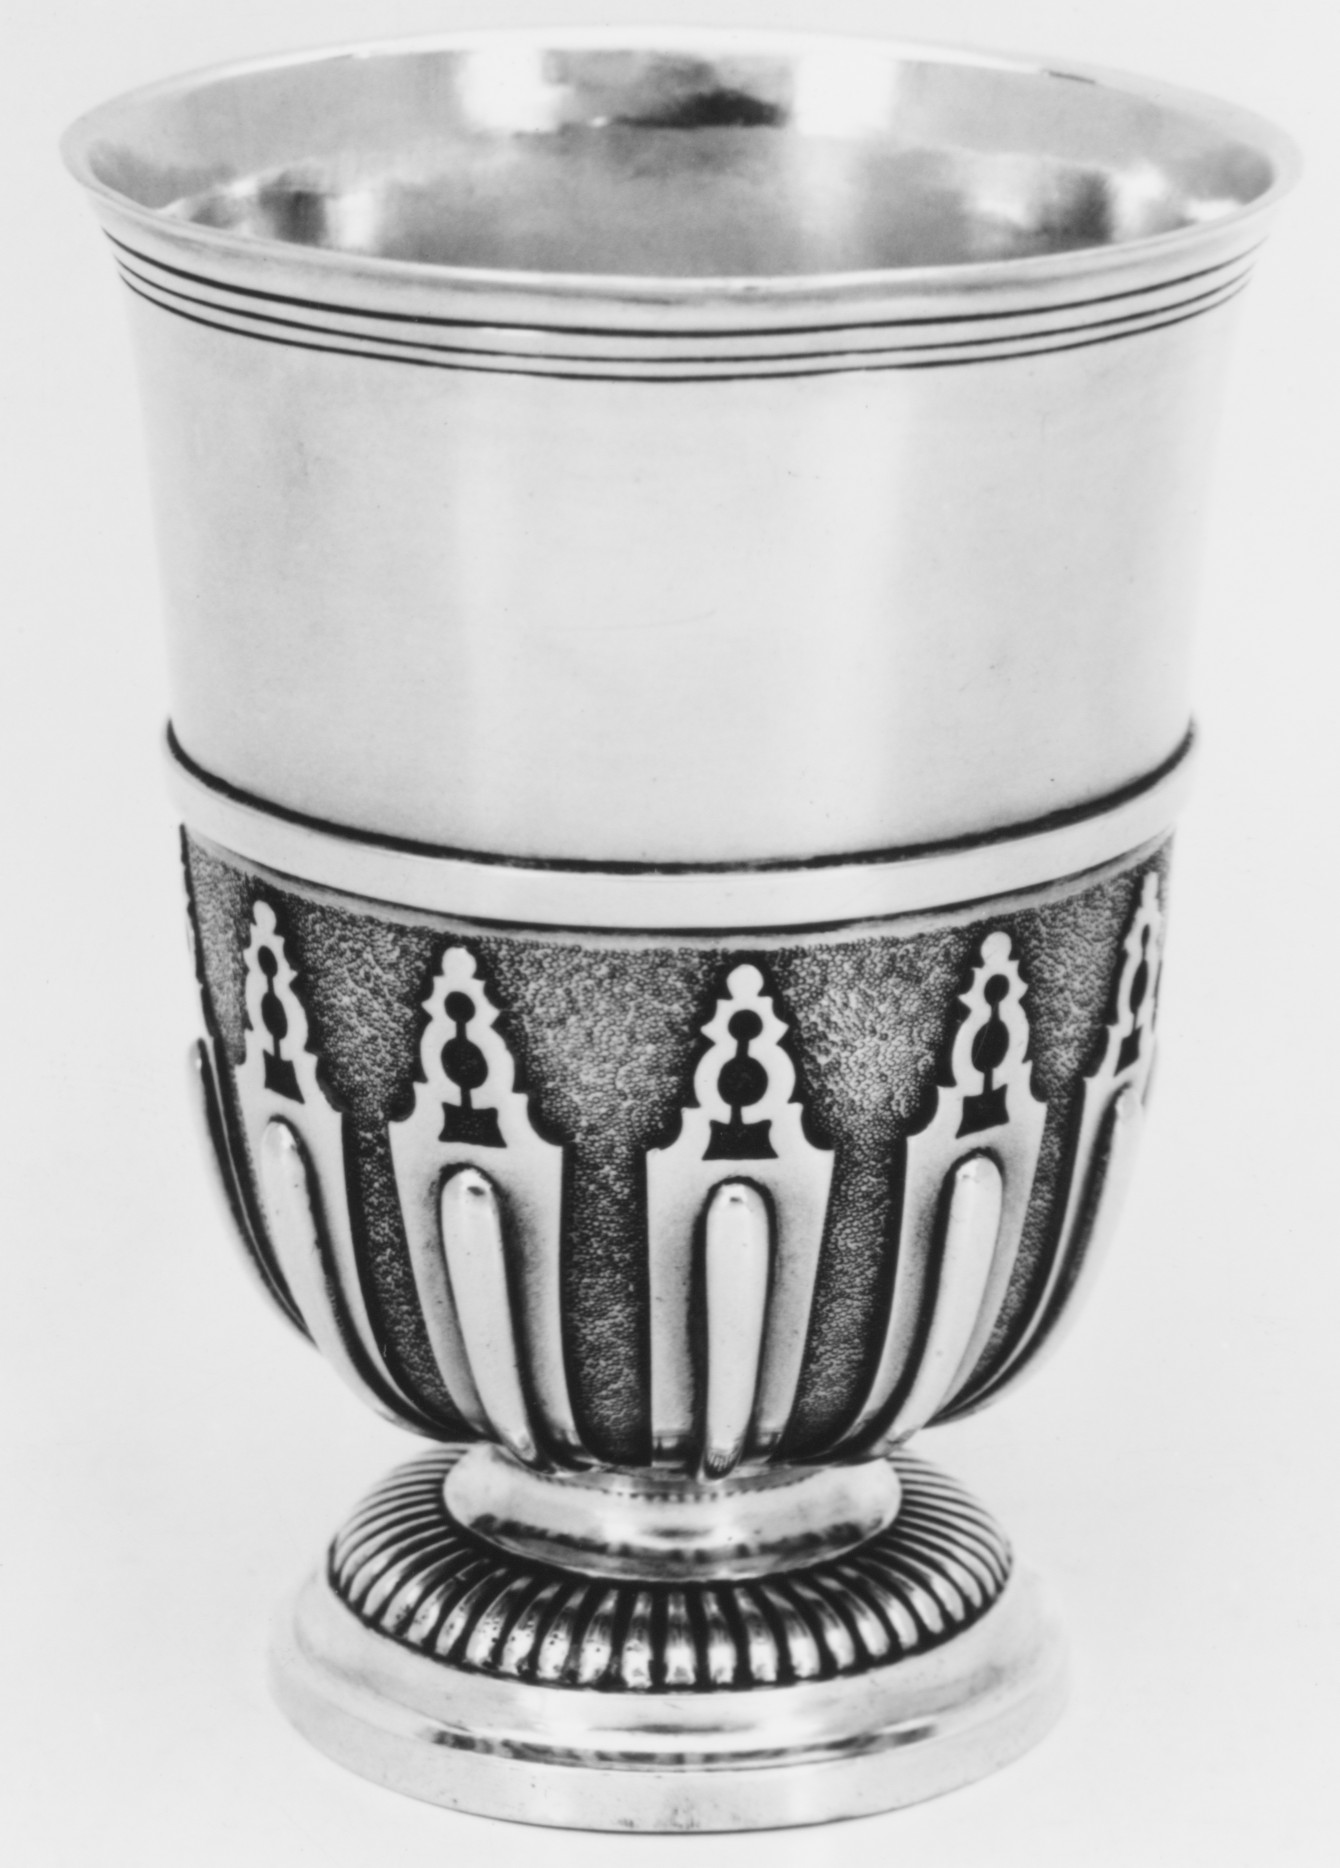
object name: beaker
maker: p.p., metz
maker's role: maker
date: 1715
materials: silver